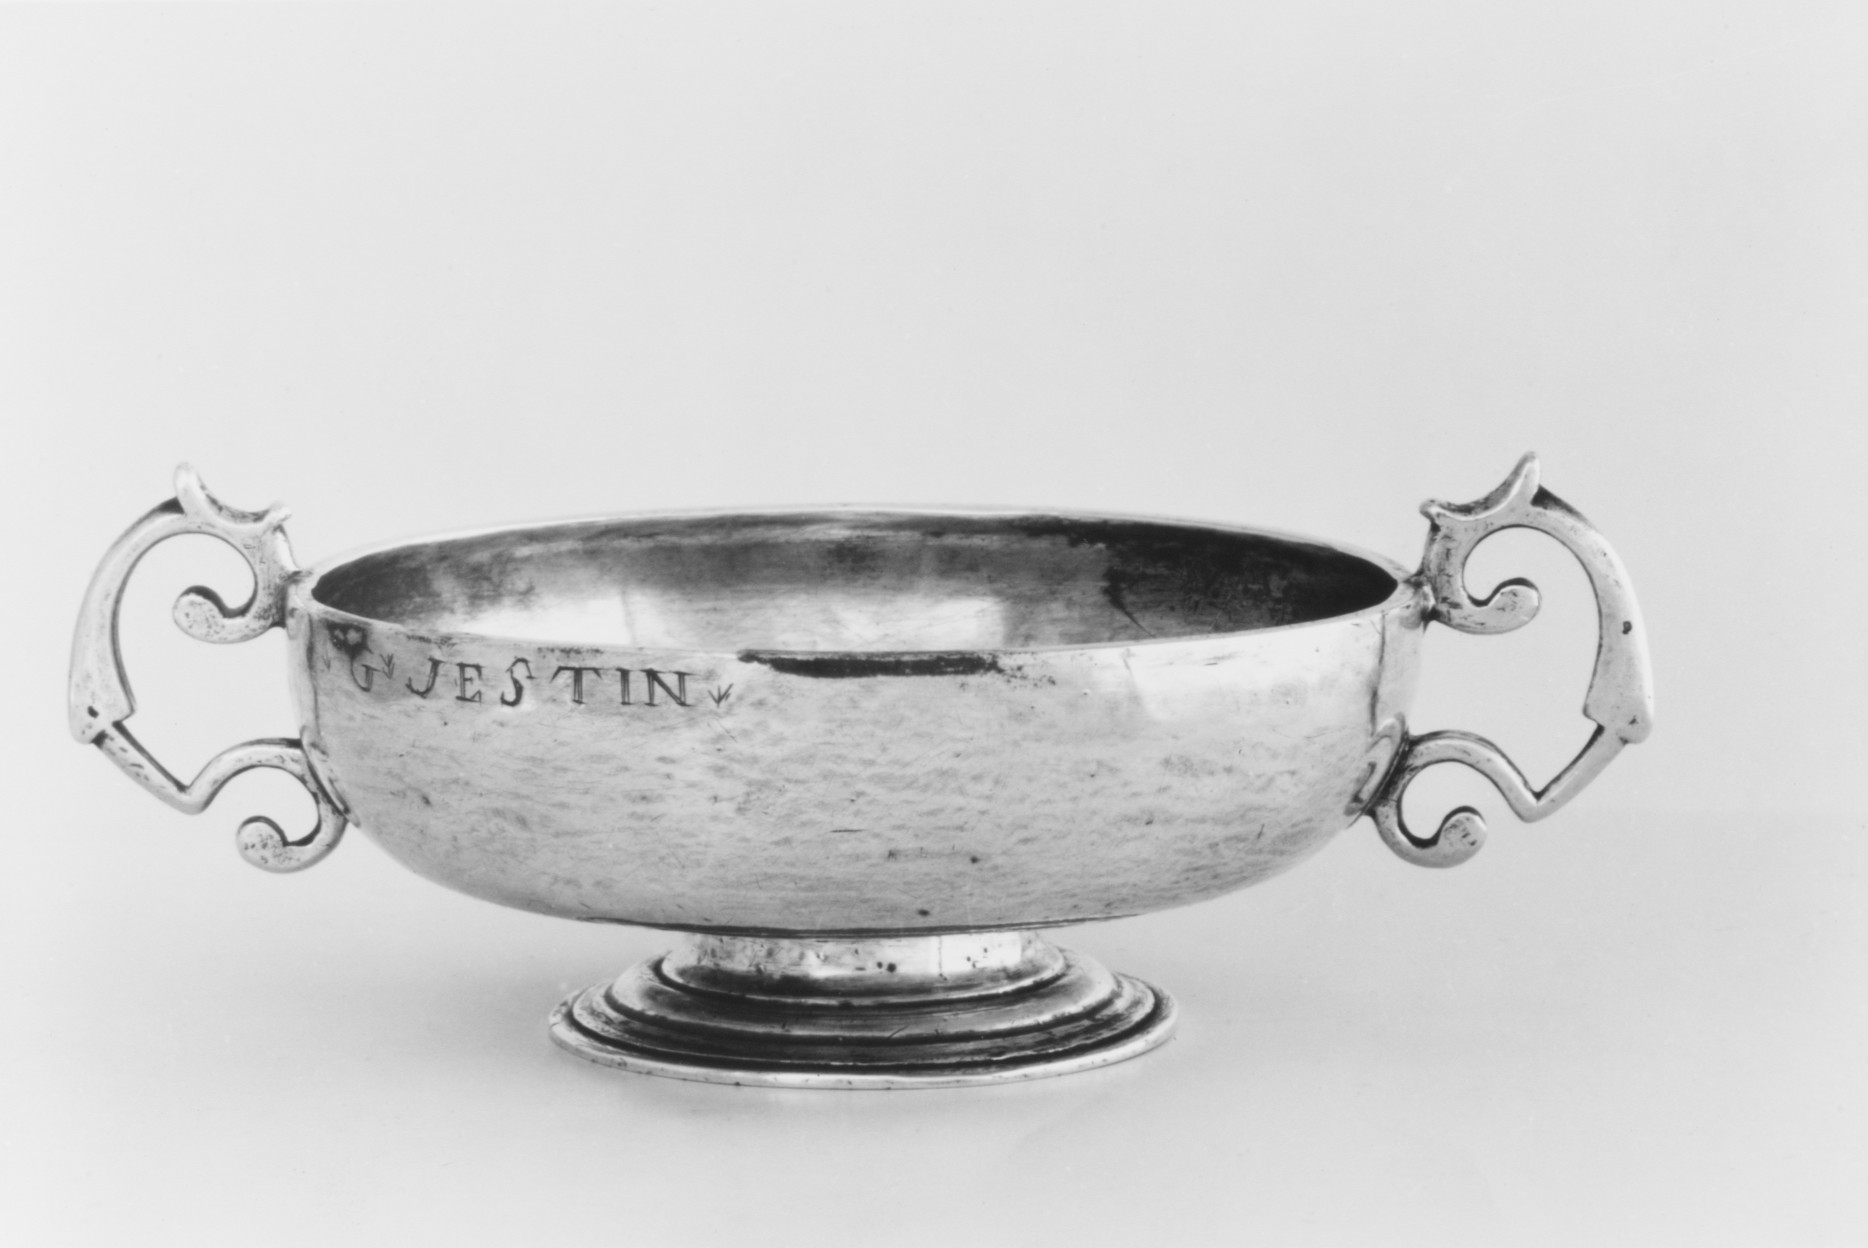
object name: collection cup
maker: guillaume hamon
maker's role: maker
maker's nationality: french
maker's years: 1683-1783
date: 1713-1753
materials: silver